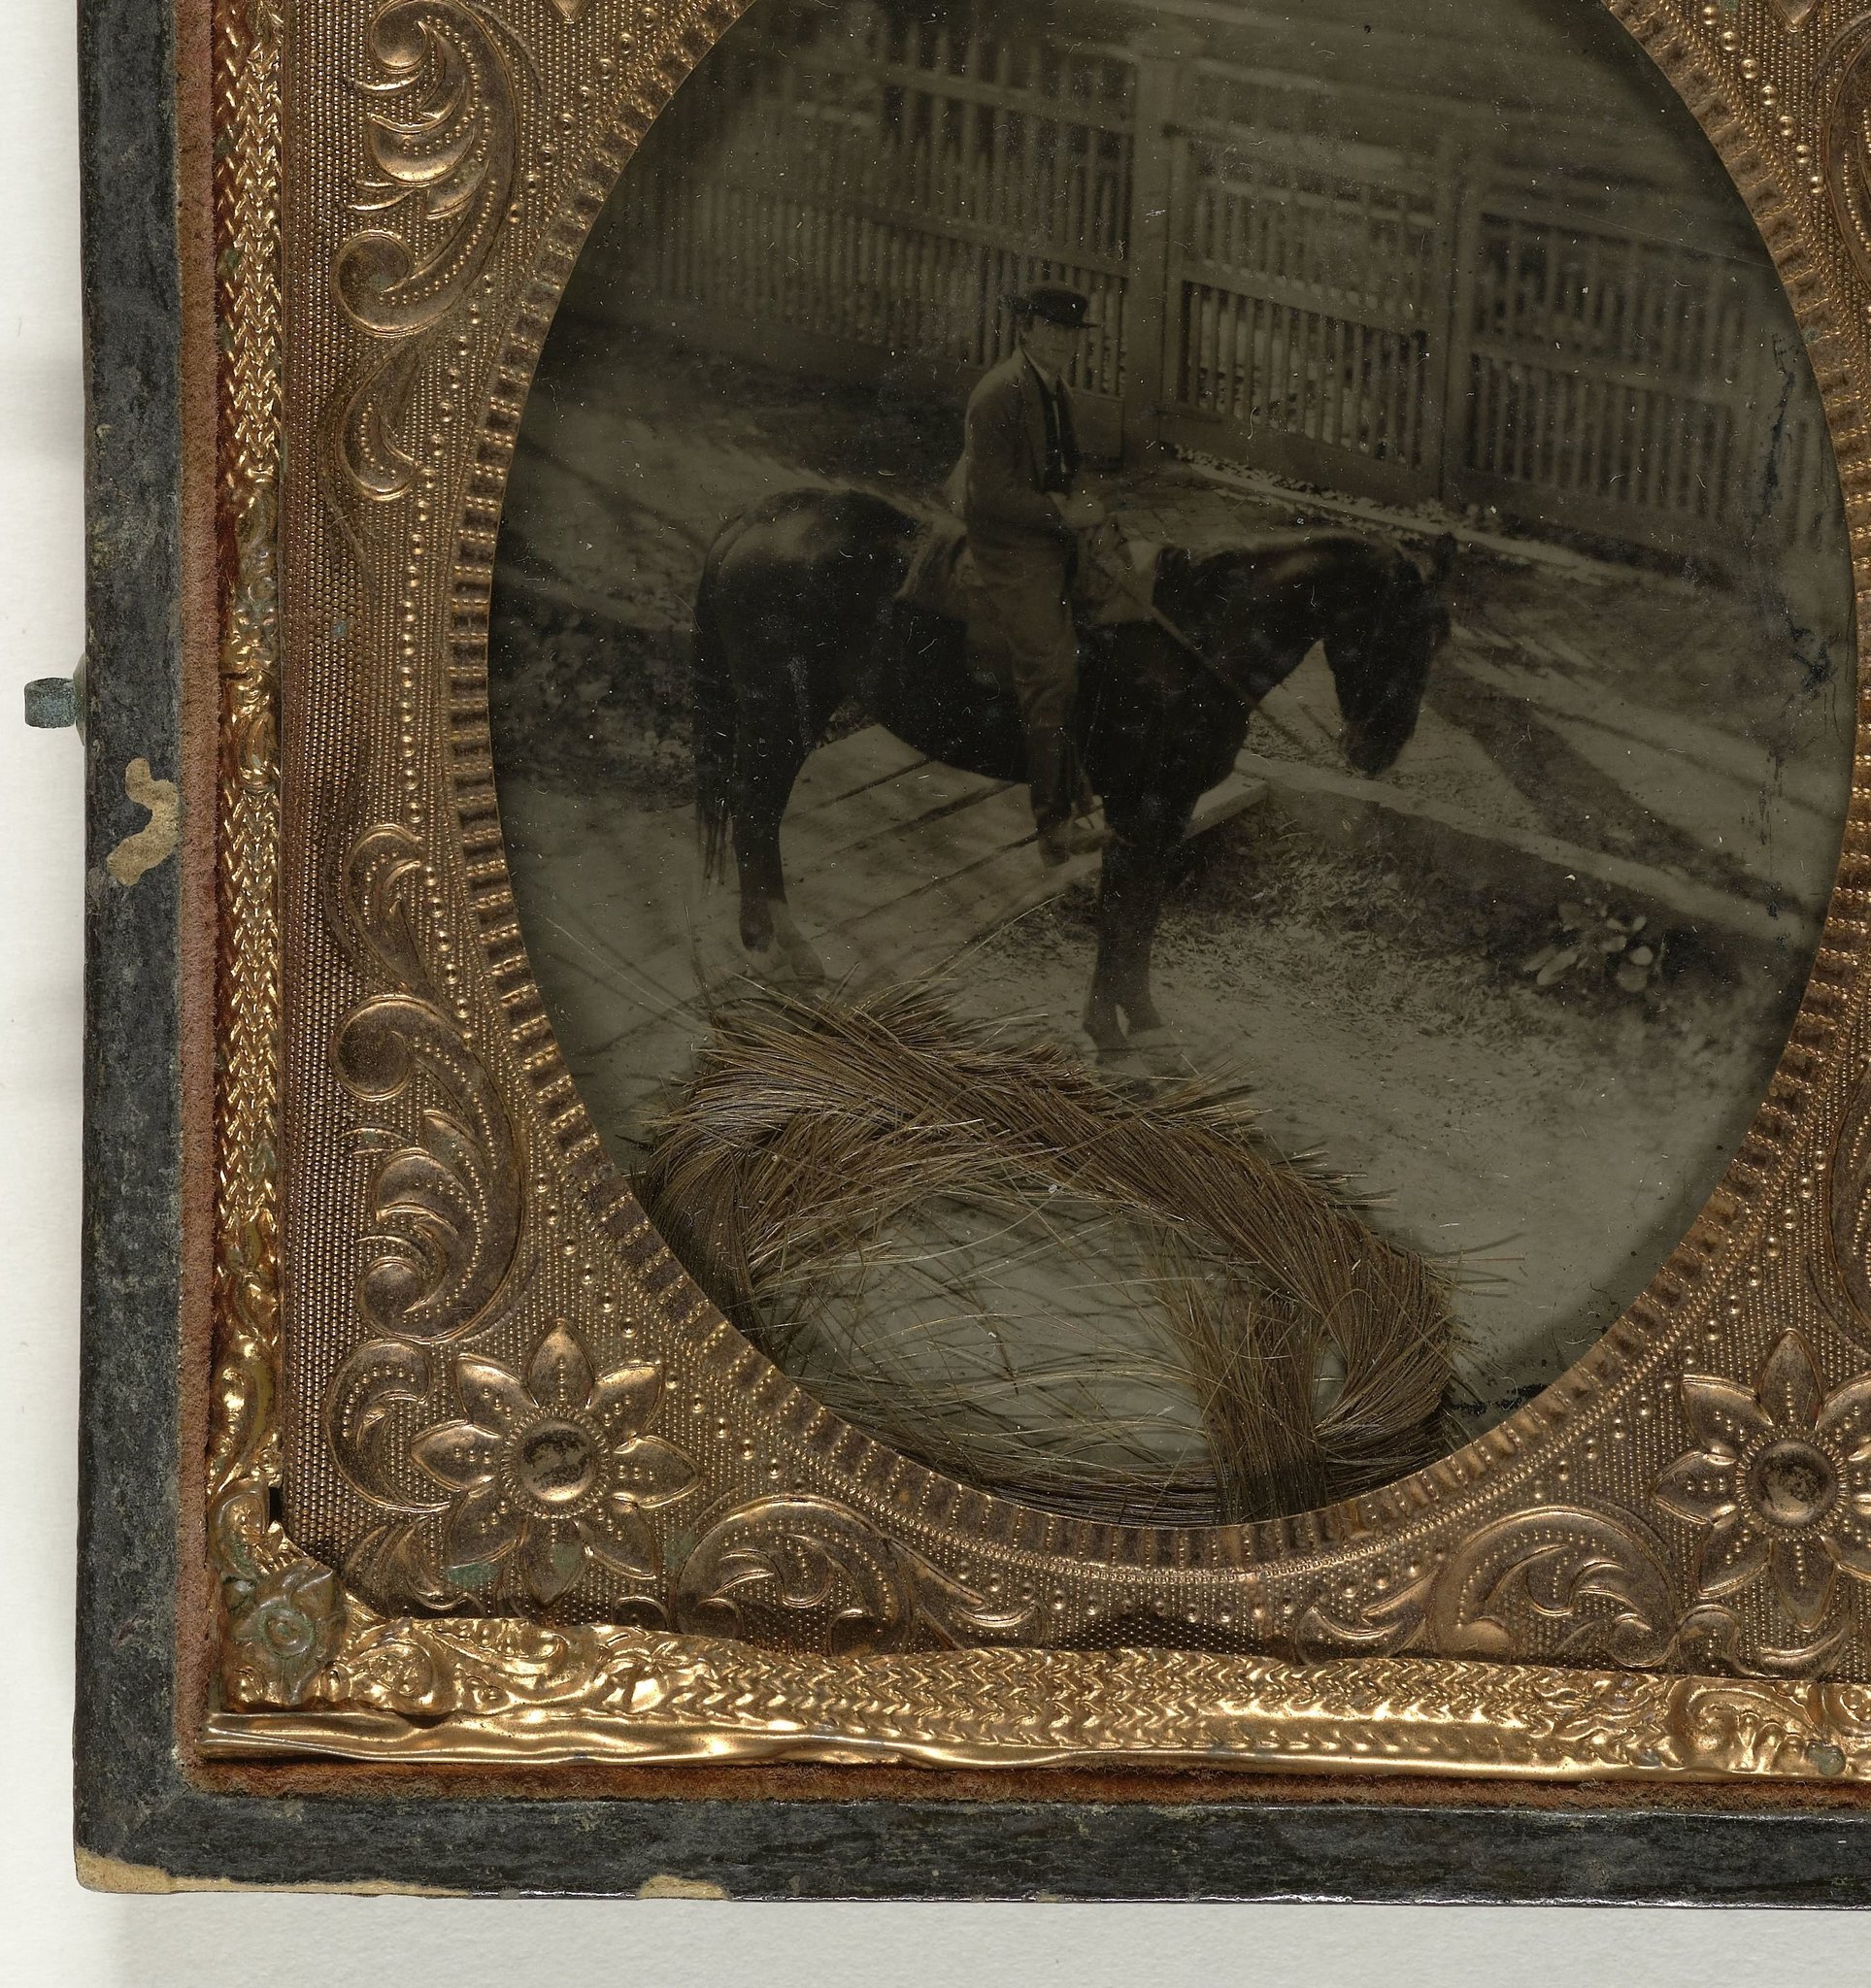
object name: photograph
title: Portret van een man te paard, schuin van boven gezien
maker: Anonymous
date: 1860-1900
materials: glass, leather, metal, tin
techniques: ferrotyping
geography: germany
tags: riding a horse, ass, or mule; rider, horseman, anonymous historical person portrayed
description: Portret van een man te paard, schuin van boven gezien. Samen met een pluk haar en RP-F-2008-88-2 in een cassette.